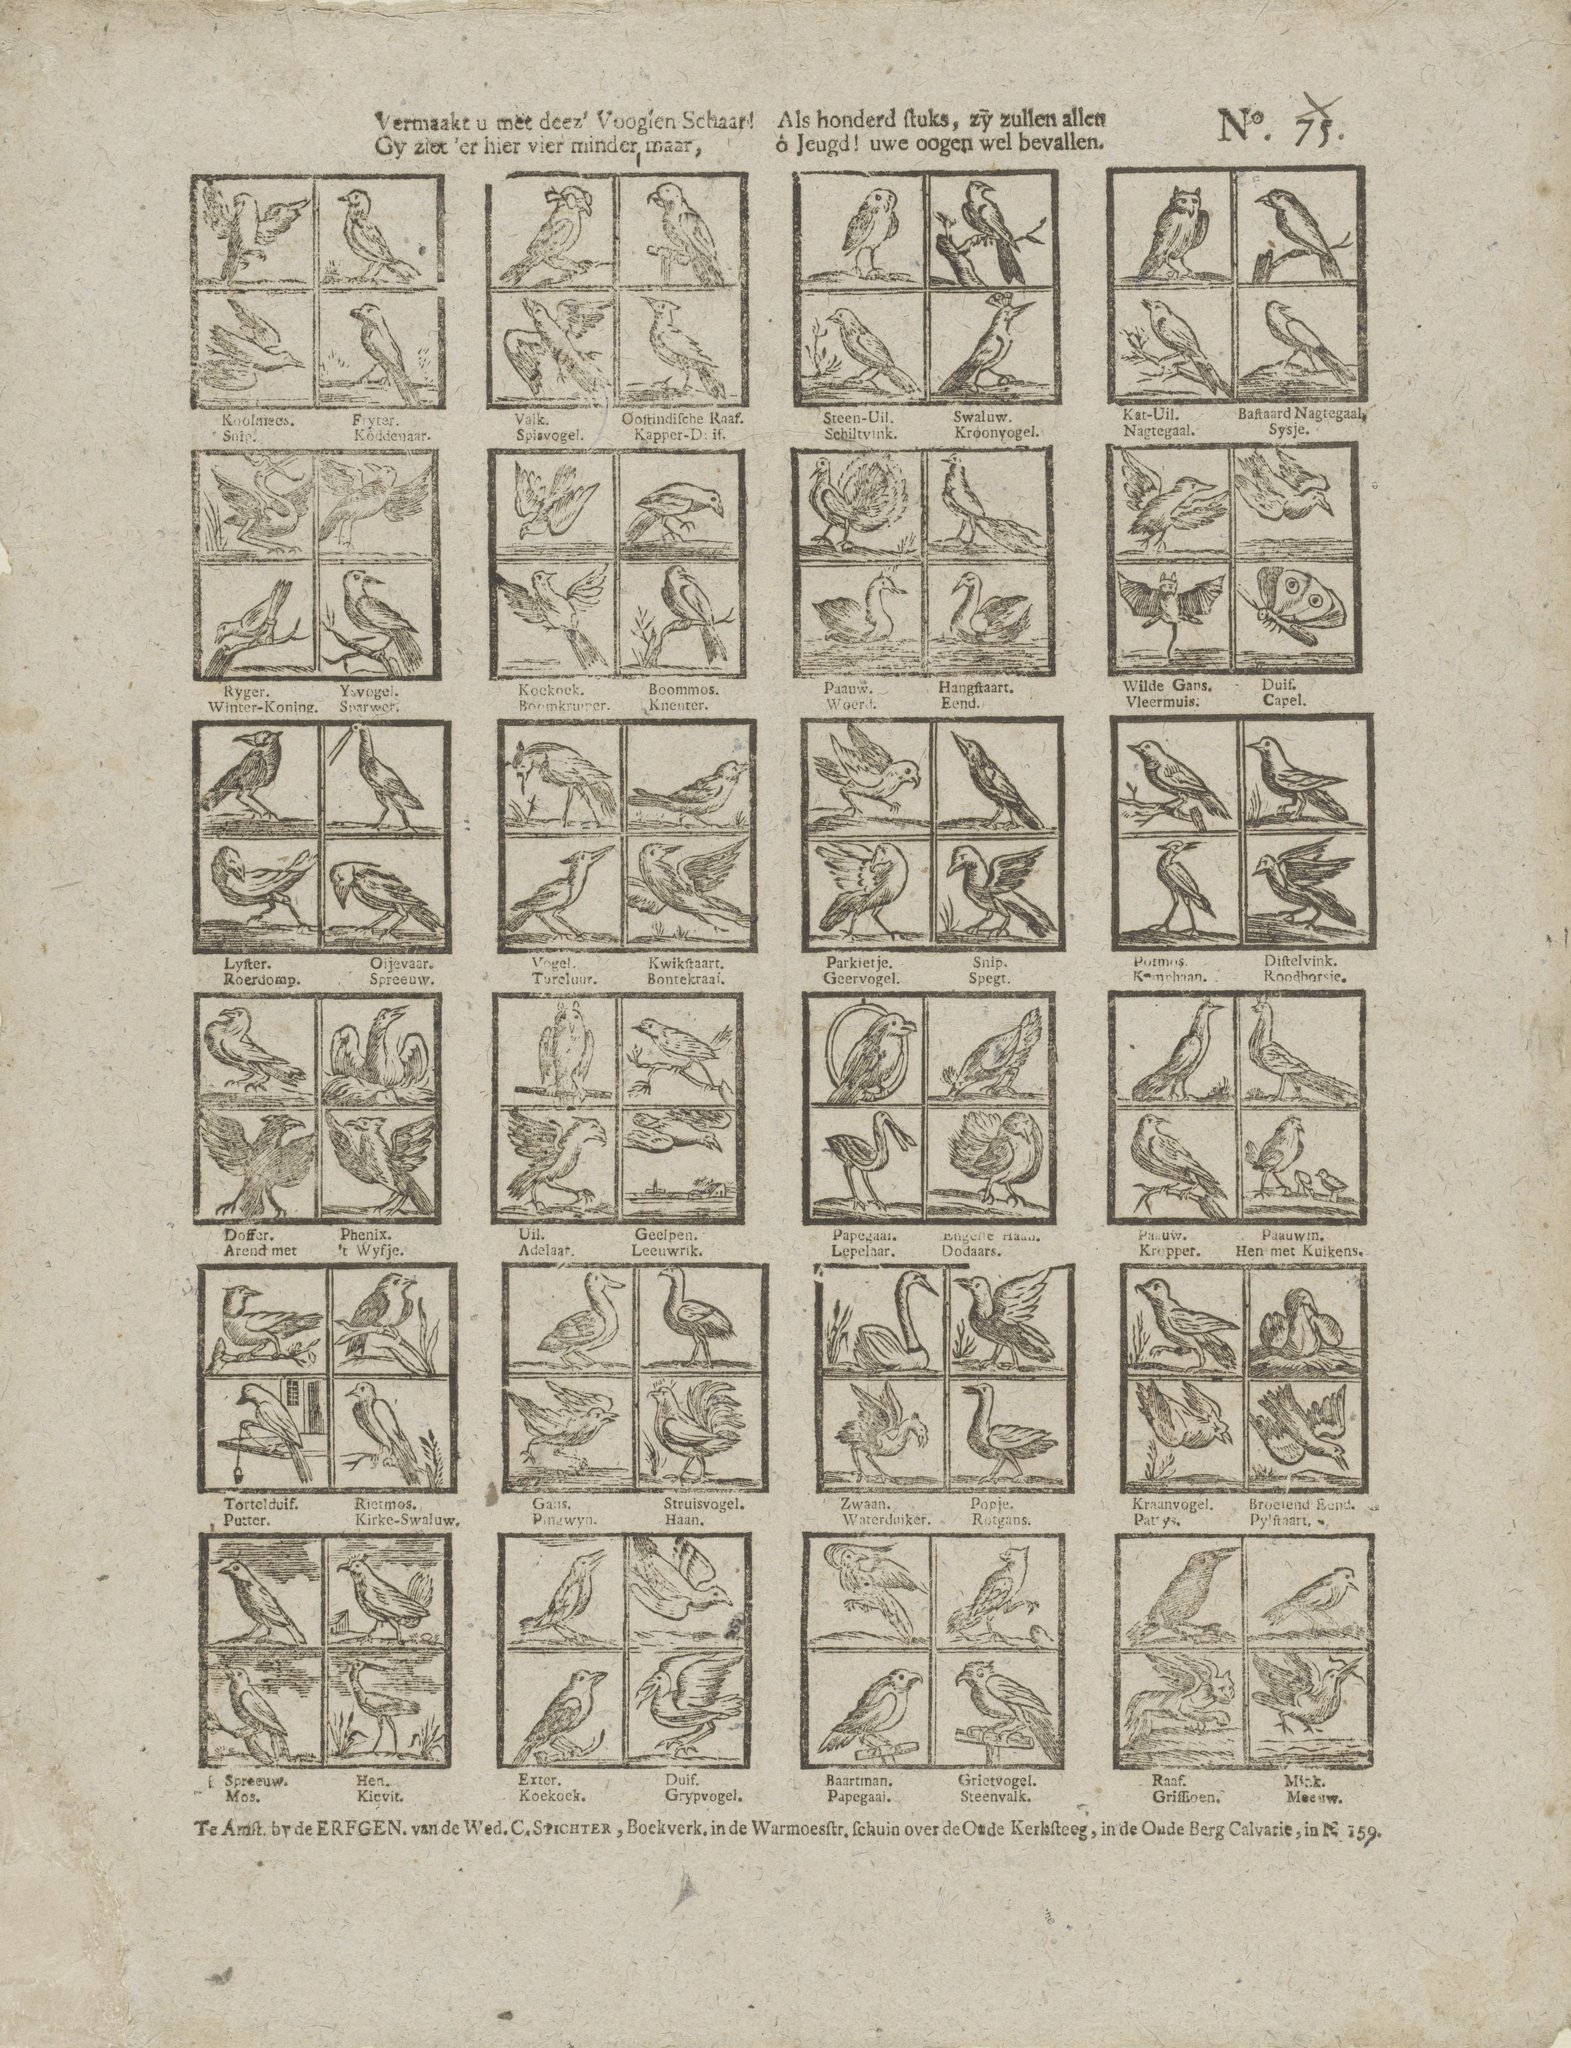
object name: print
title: Vermaakt u met deez' vooglen-schaar! / Gy ziet 'er hier minder maar, / Als honderd stuks, zy zullen allen / ô jeugd! uwe oogen wel bevallen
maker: Anonymous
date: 1715-1813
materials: paper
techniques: letterpress printing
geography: amsterdam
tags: flying mammals: bat, birds, insects: butterfly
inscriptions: collector's mark: Lugt 2760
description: Blad met 24 voorstellingen met elk vier gevleugelde dieren, zoals vogels, een uil, een vleermuis en een vlinder, de zgn. Groote Vogelkooi. Onder elke voorstelling de namen van de dieren. Genummerd rechtsboven: No. 75